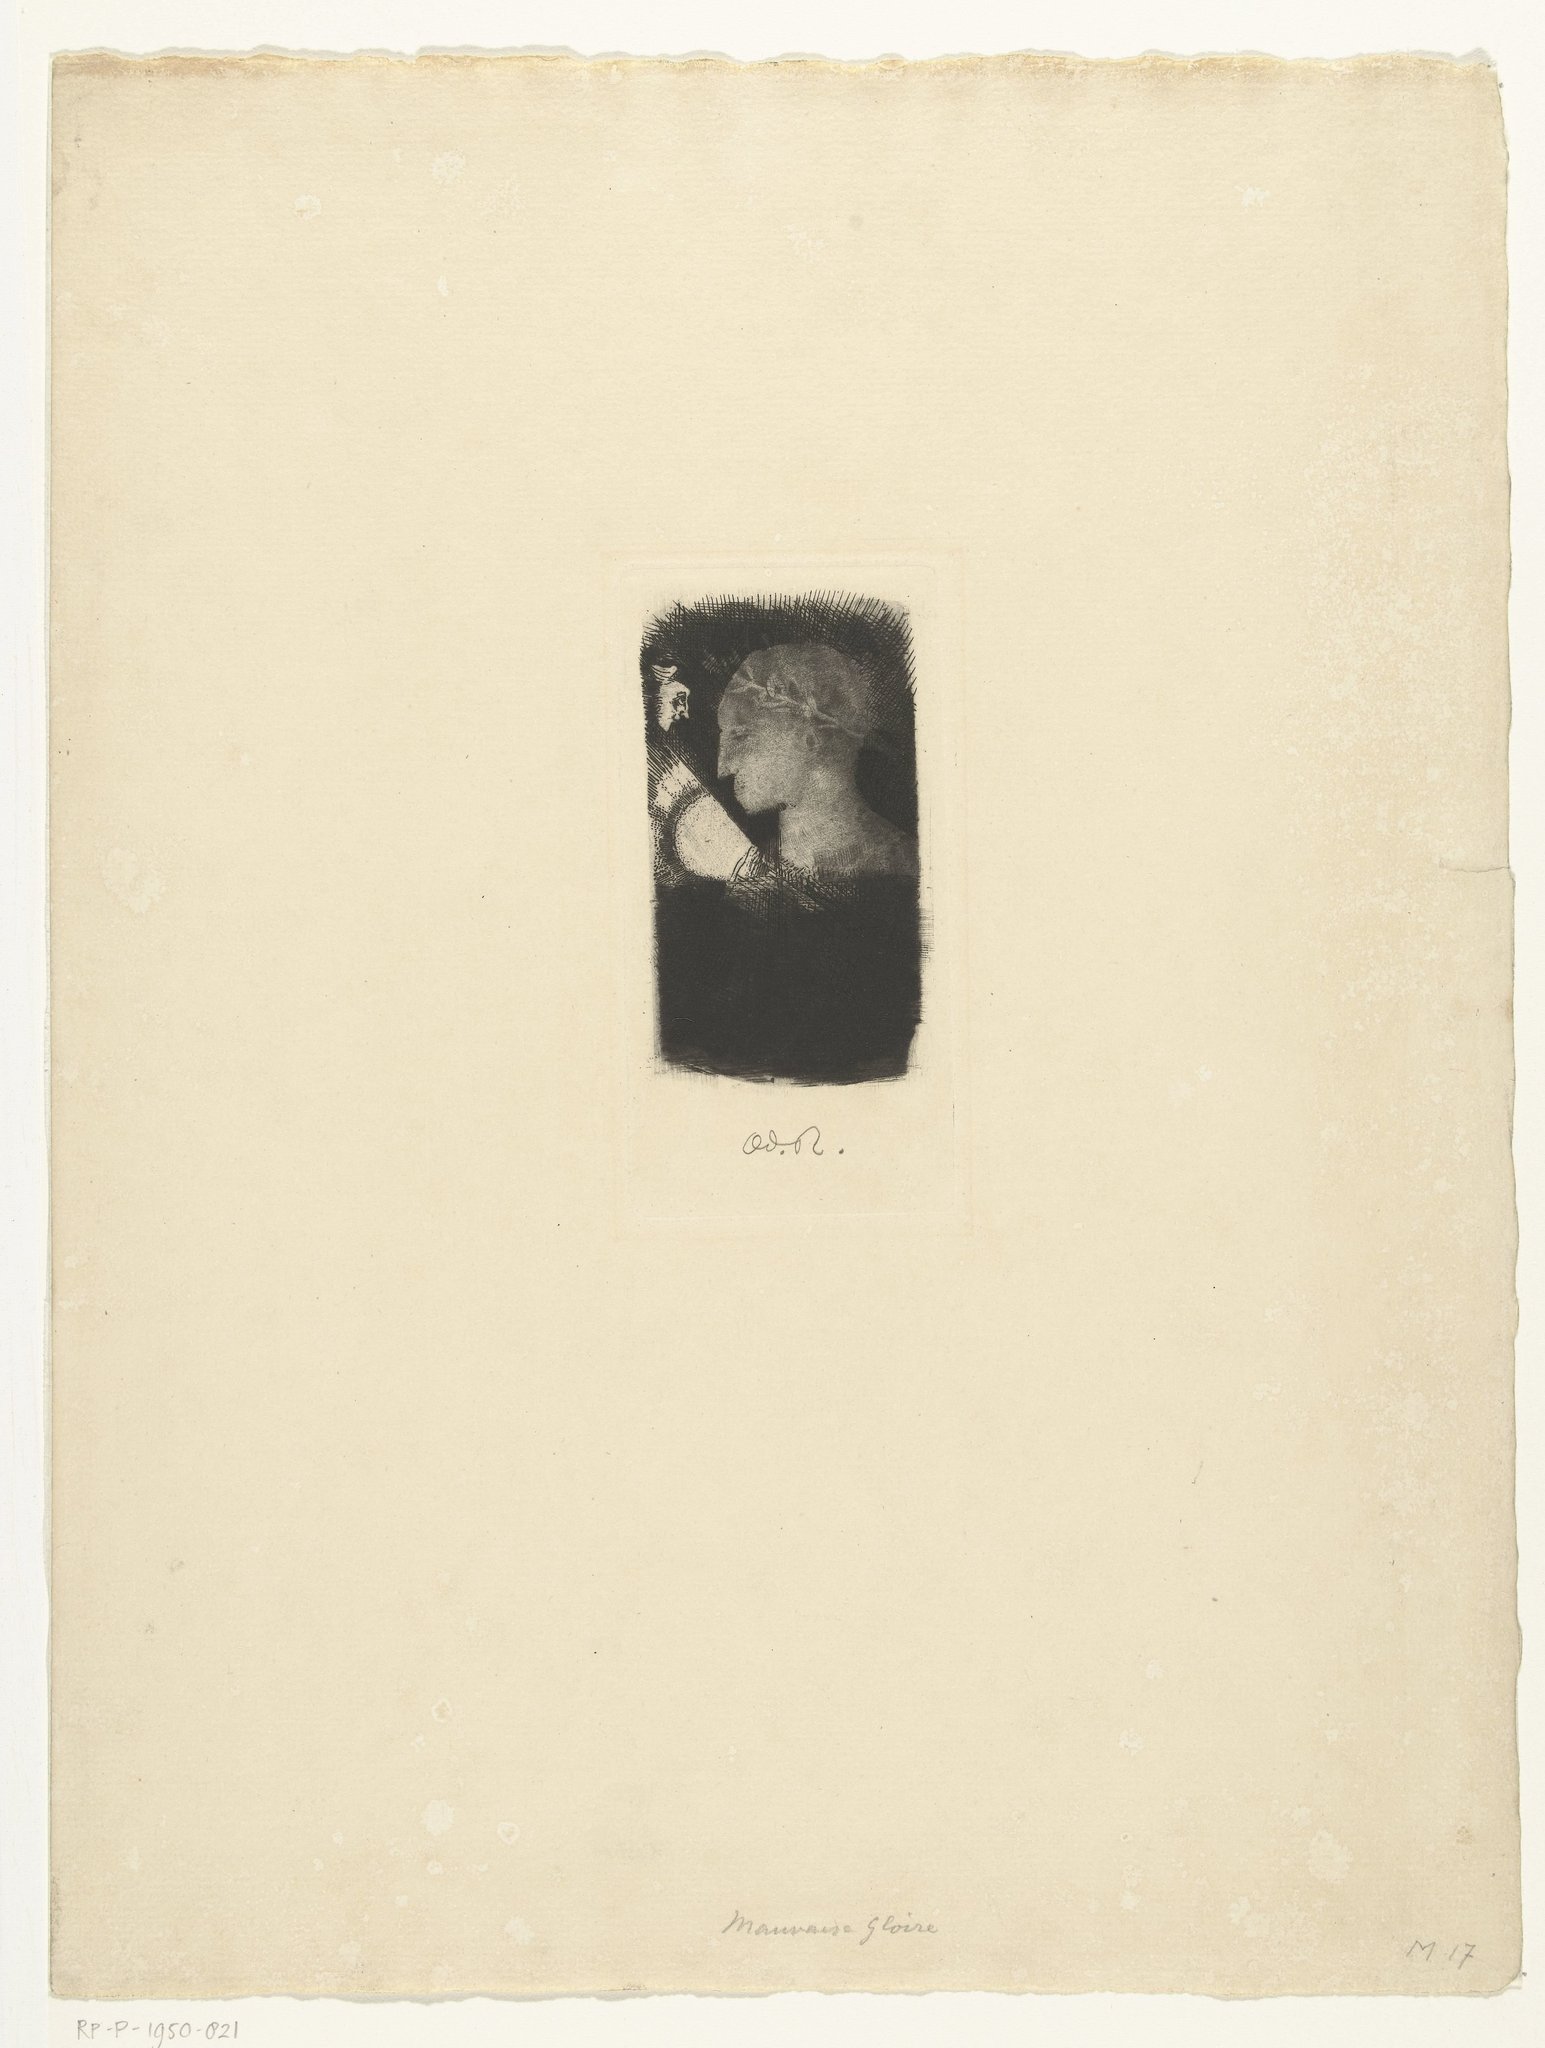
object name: print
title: Mauvaise gloire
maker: odilon redon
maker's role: draughtsman, painter, print maker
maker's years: 1840-1916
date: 1886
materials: paper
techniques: drypoint, etching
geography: france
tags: classical history (+ (full) bust), crowning with laurel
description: Buste van een man met een lauwerkrans, een tweede hoofd linksboven.